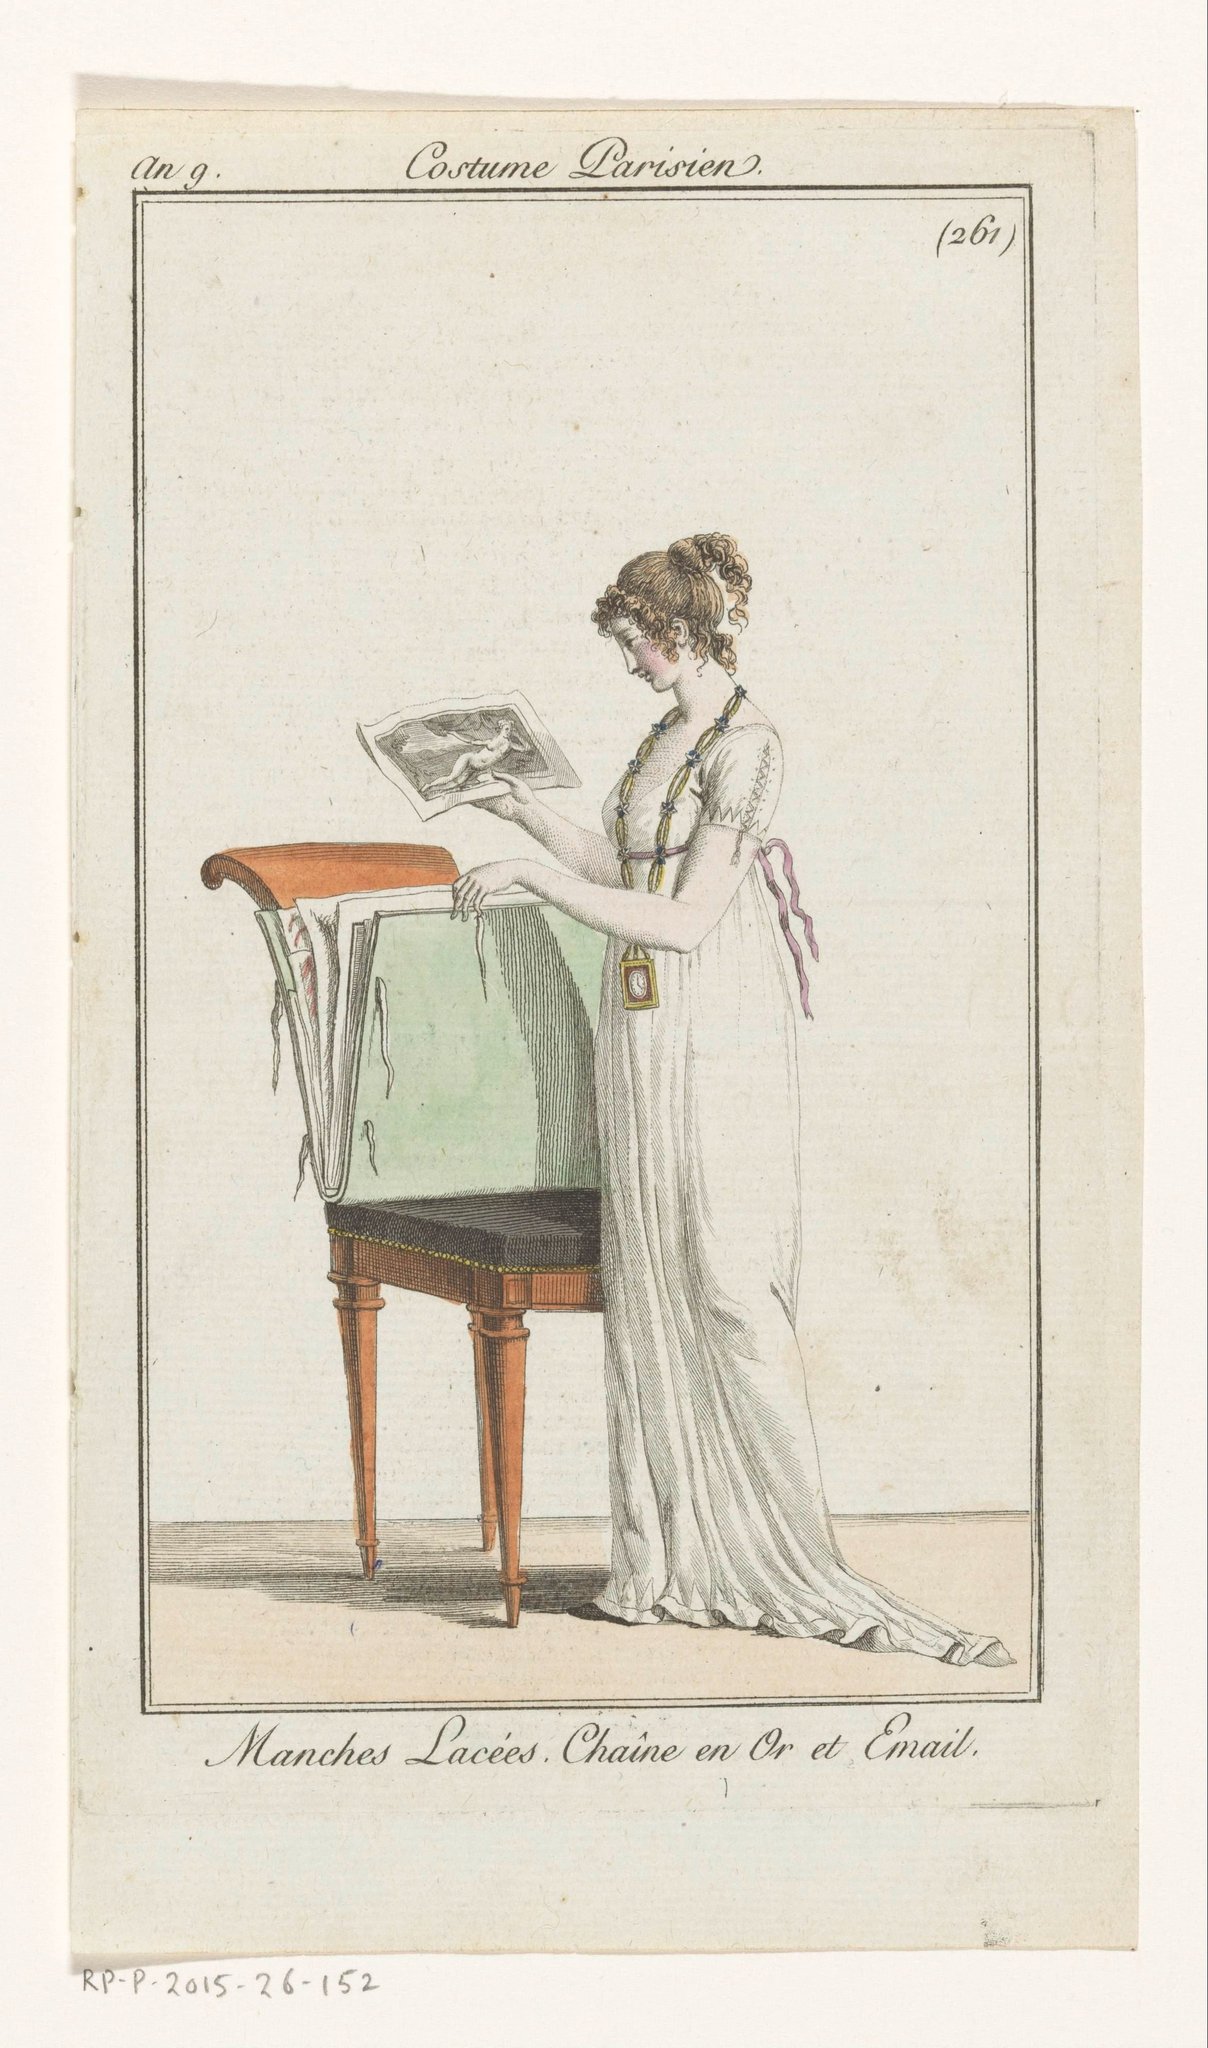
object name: fashion print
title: Jonge vrouw haalt een prent of tekening uit een portfolio dat op een stoel rust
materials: paper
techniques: etching, hand coloring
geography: paris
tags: fashion plates, art collecting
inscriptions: collector's mark: Lugt 4780, collector's mark: Lugt 2228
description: Prent uit het modetijdschrift Journal des Dames et des Modes. Paris: Sellèque en Mésangère, 1797-1839.